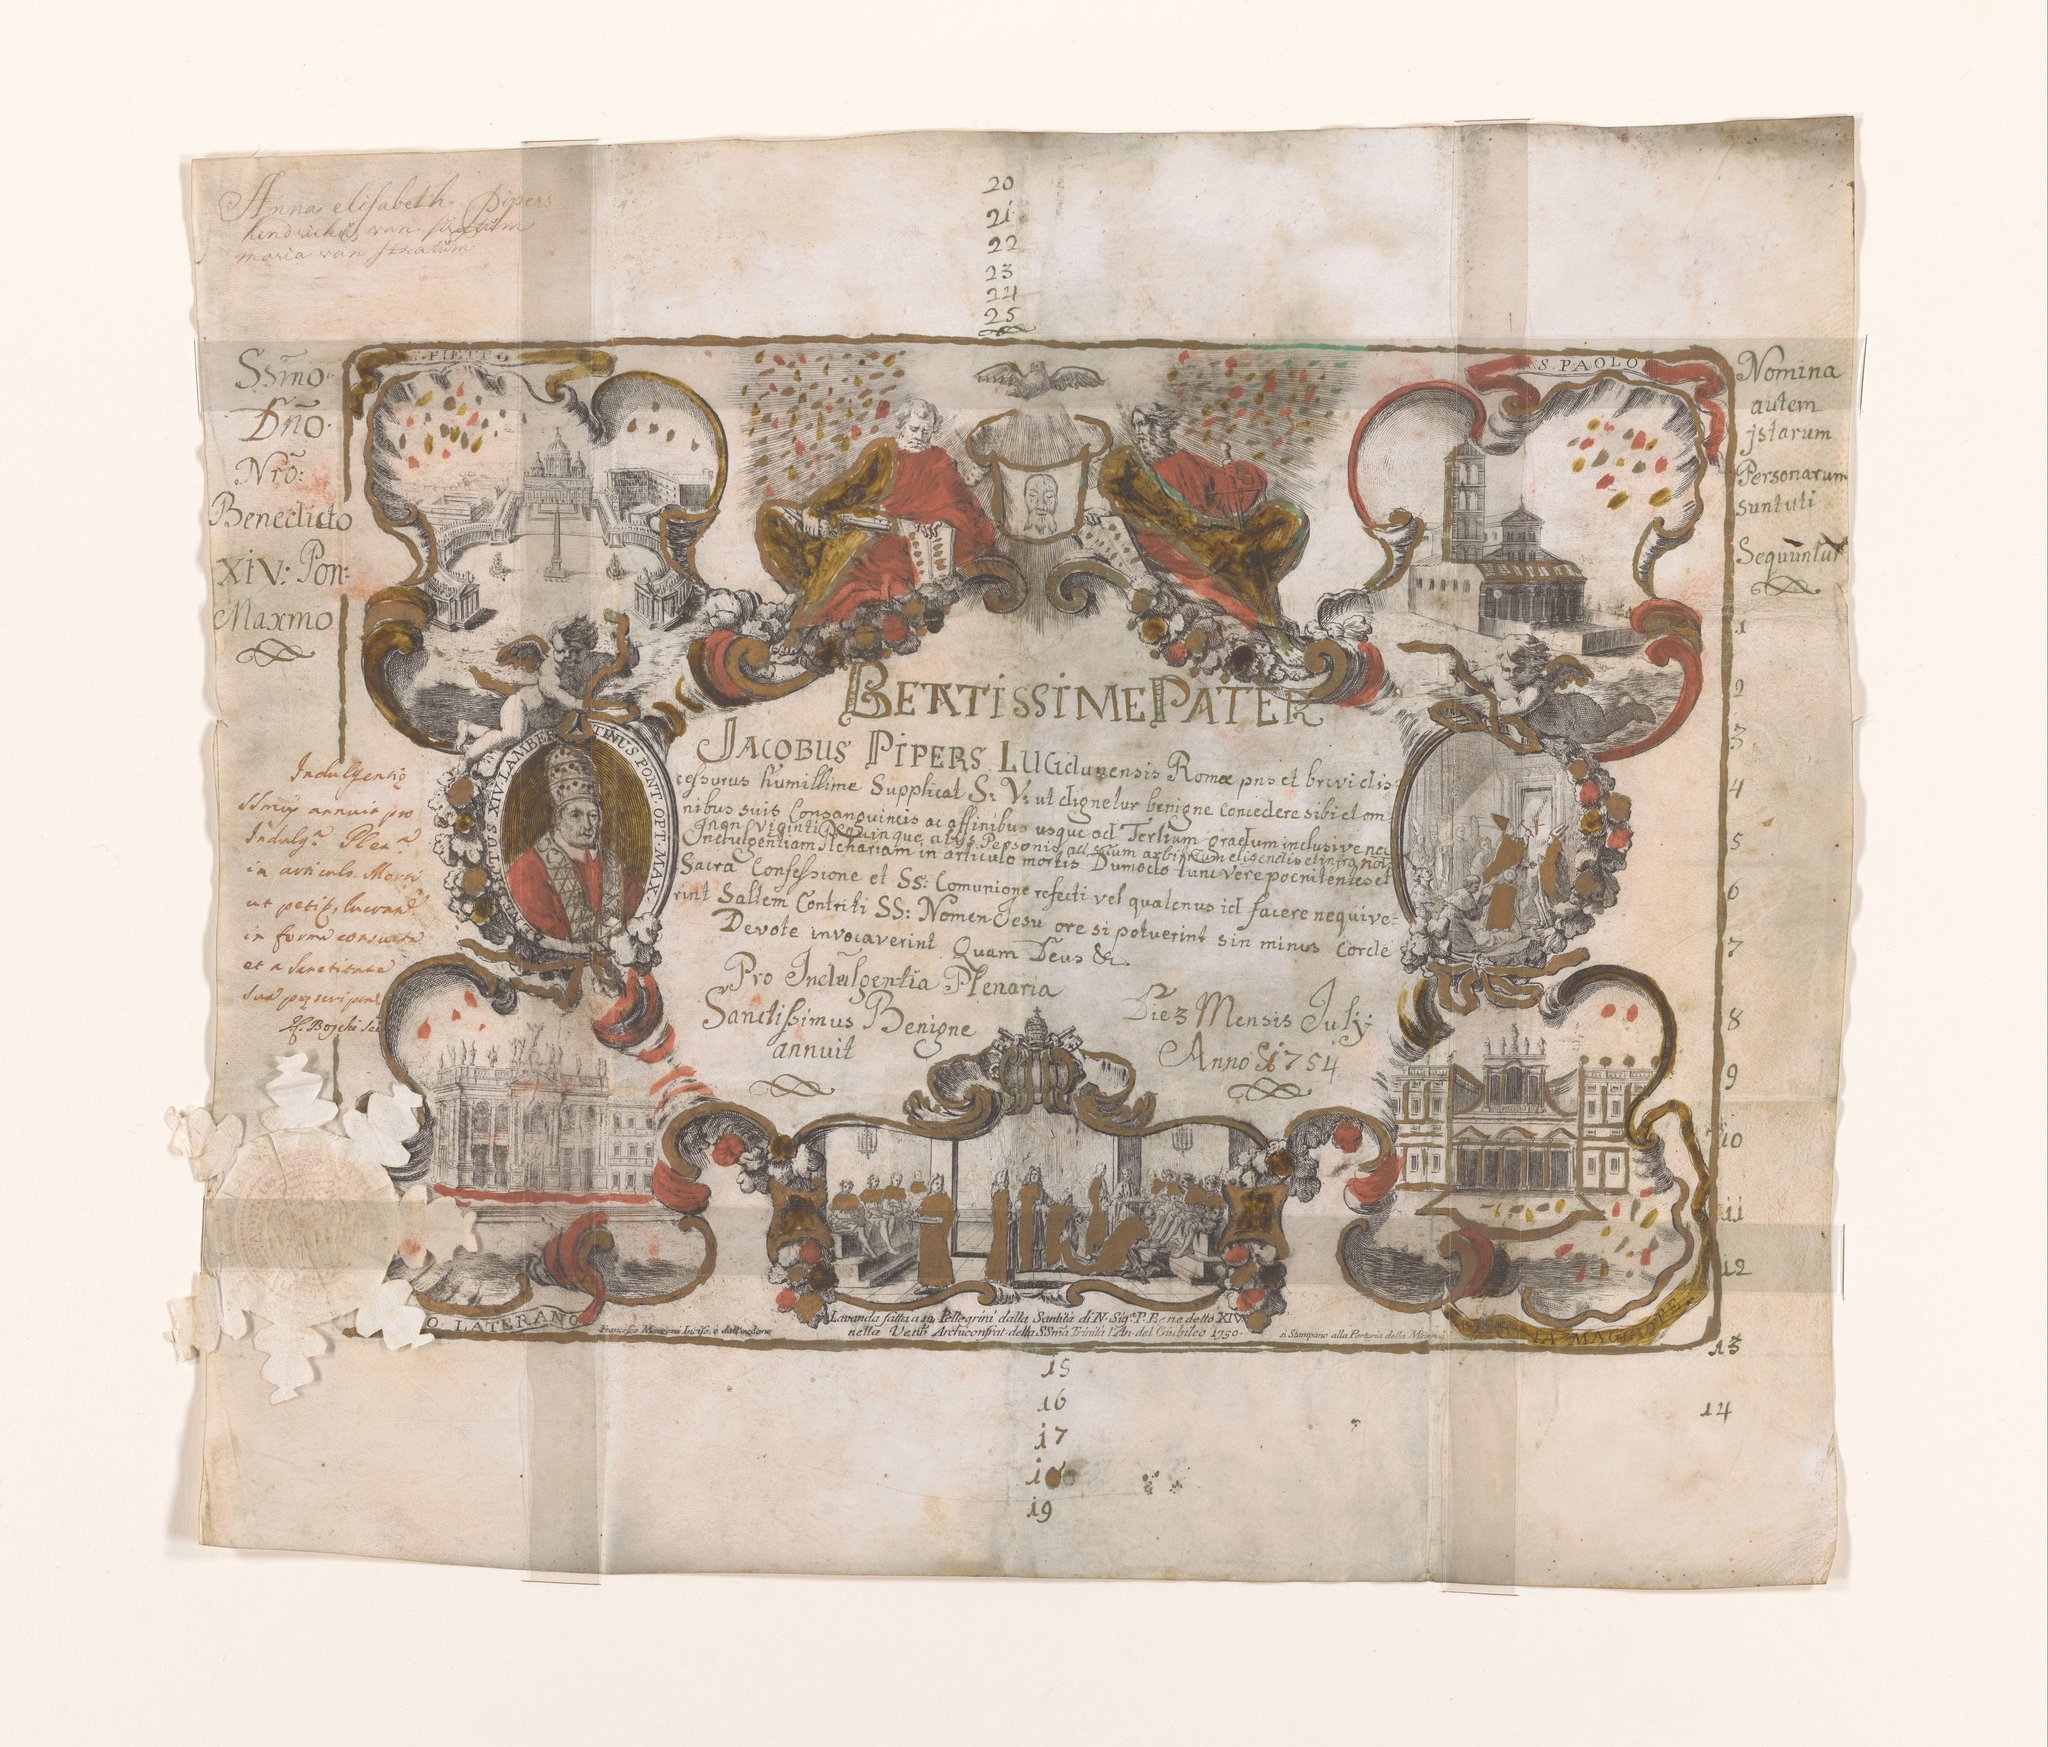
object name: document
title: Aflaatbrief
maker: francesco manzoni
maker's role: print maker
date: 1754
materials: ink, parchment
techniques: colour, engraving, writing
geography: rome